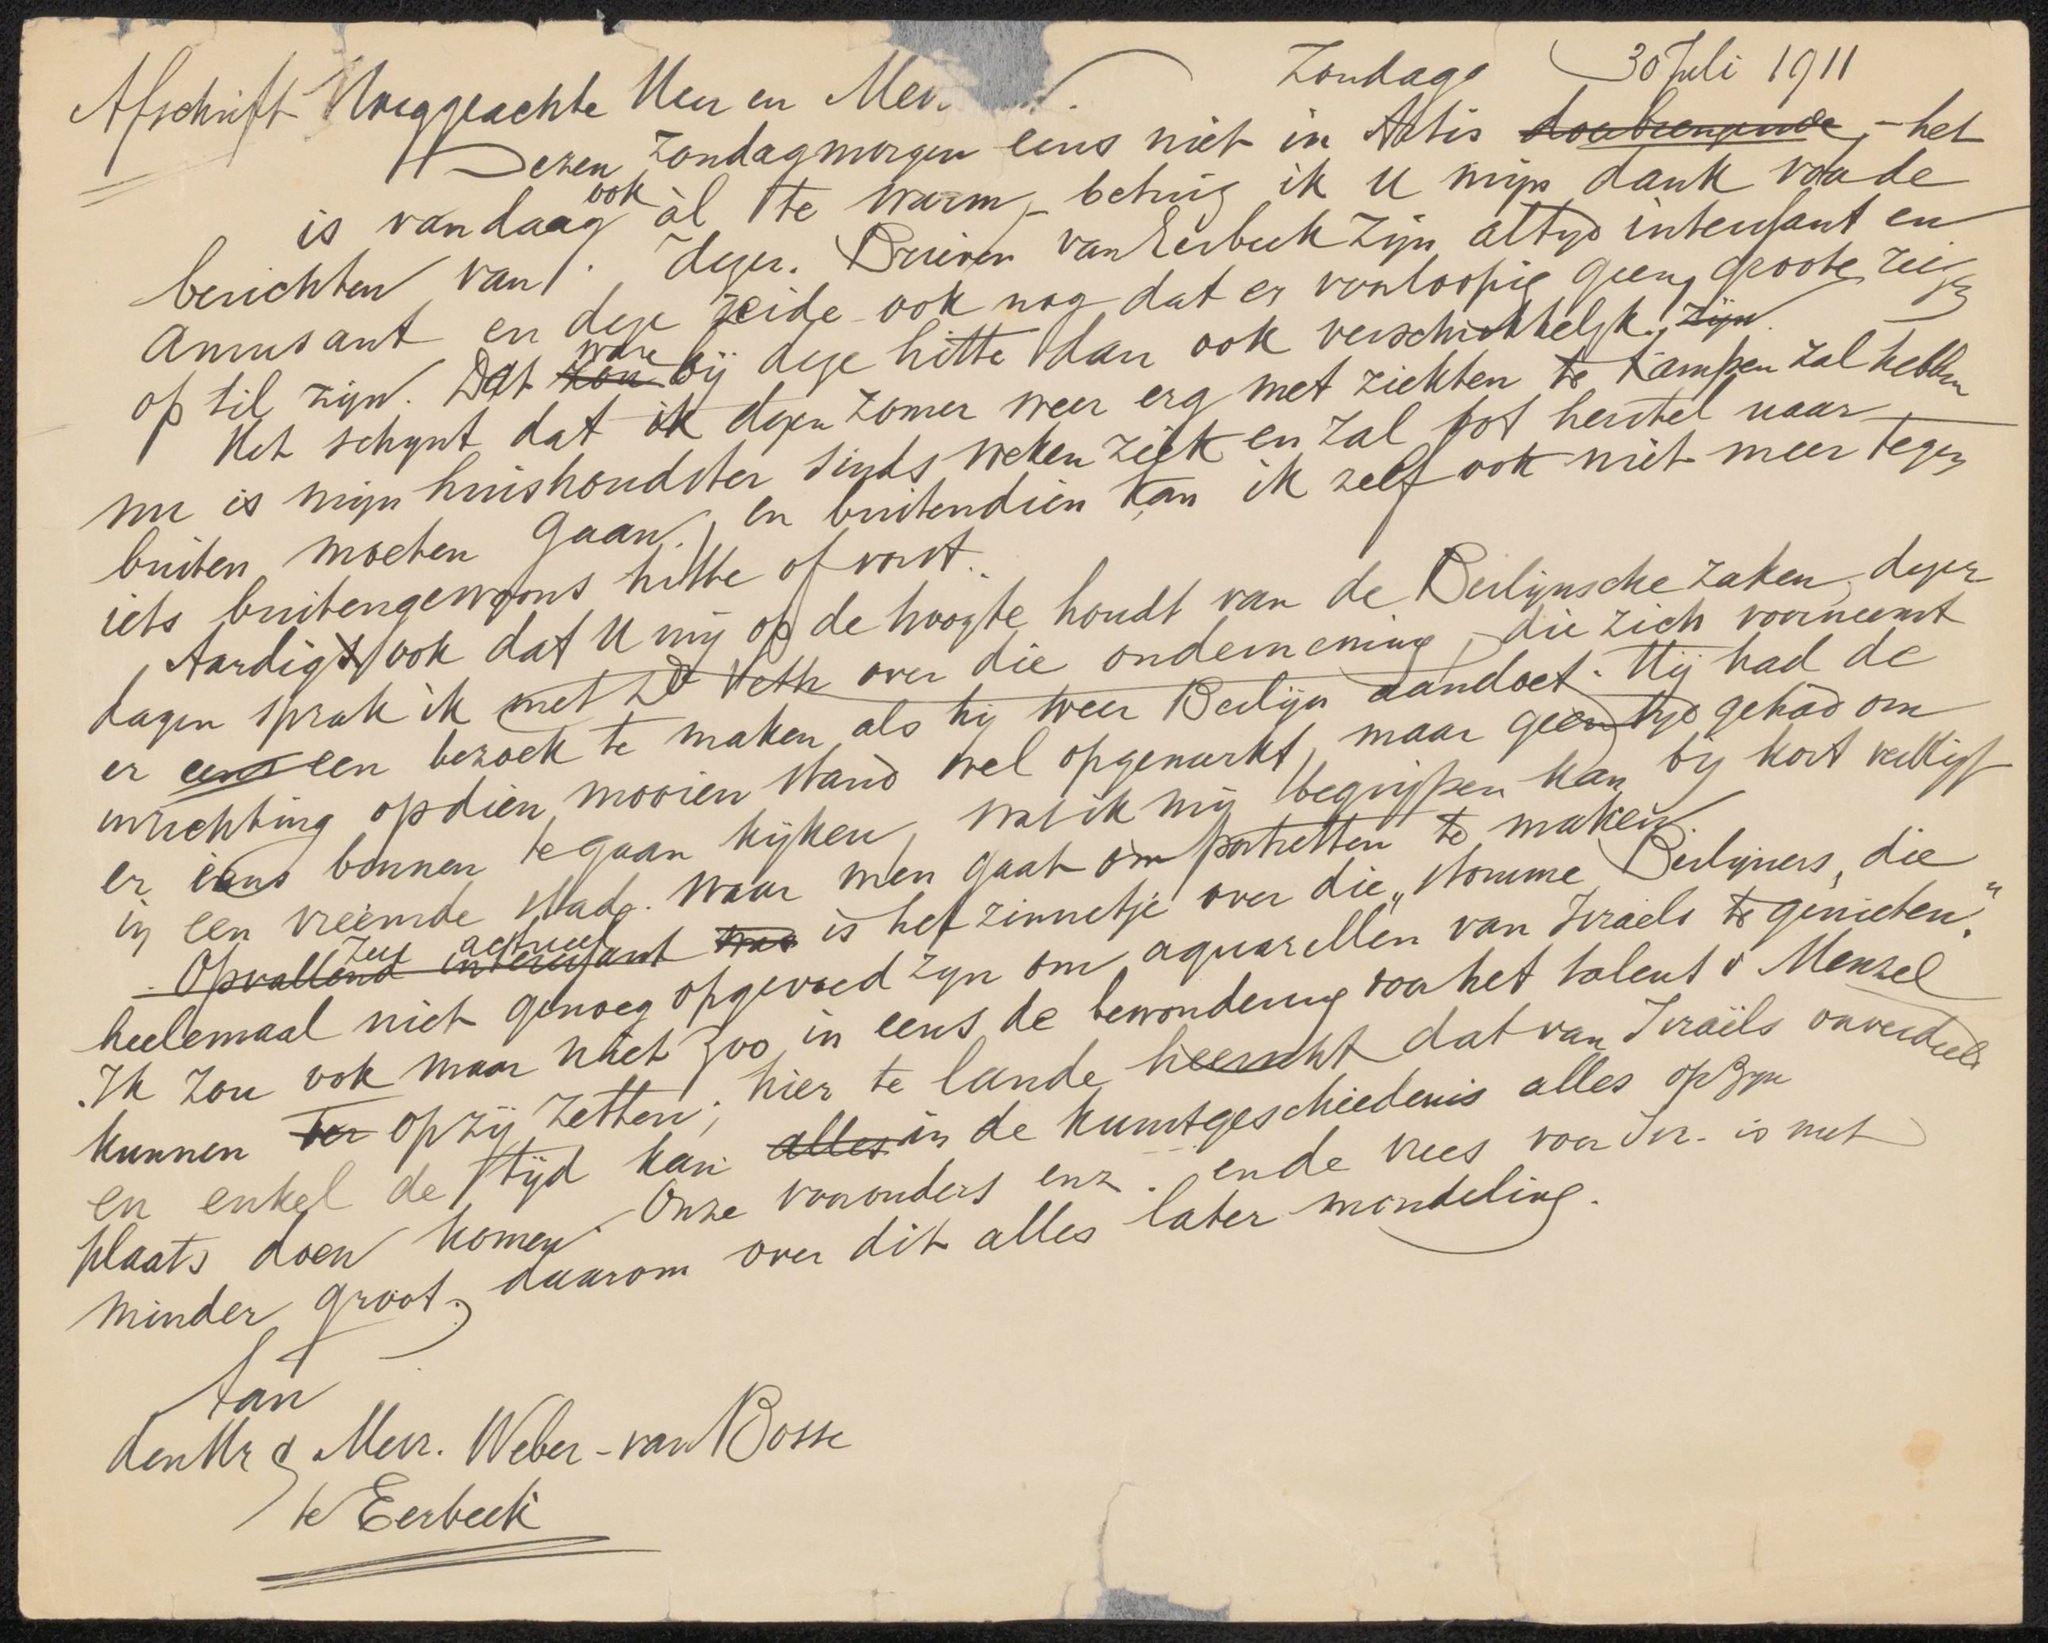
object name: letter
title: Brief aan Max Wilhelm Carl Weber en Anne Antoinette Weber-Van Bosse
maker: august allebé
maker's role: draughtsman, print maker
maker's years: 1838-1927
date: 1911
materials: ink, paper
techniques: pen, writing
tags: the hague, painter, jozef israëls, dordrecht, jan veth, anne antoinette weber-van bosse, anonymous historical person portrayed, diseases, berlin